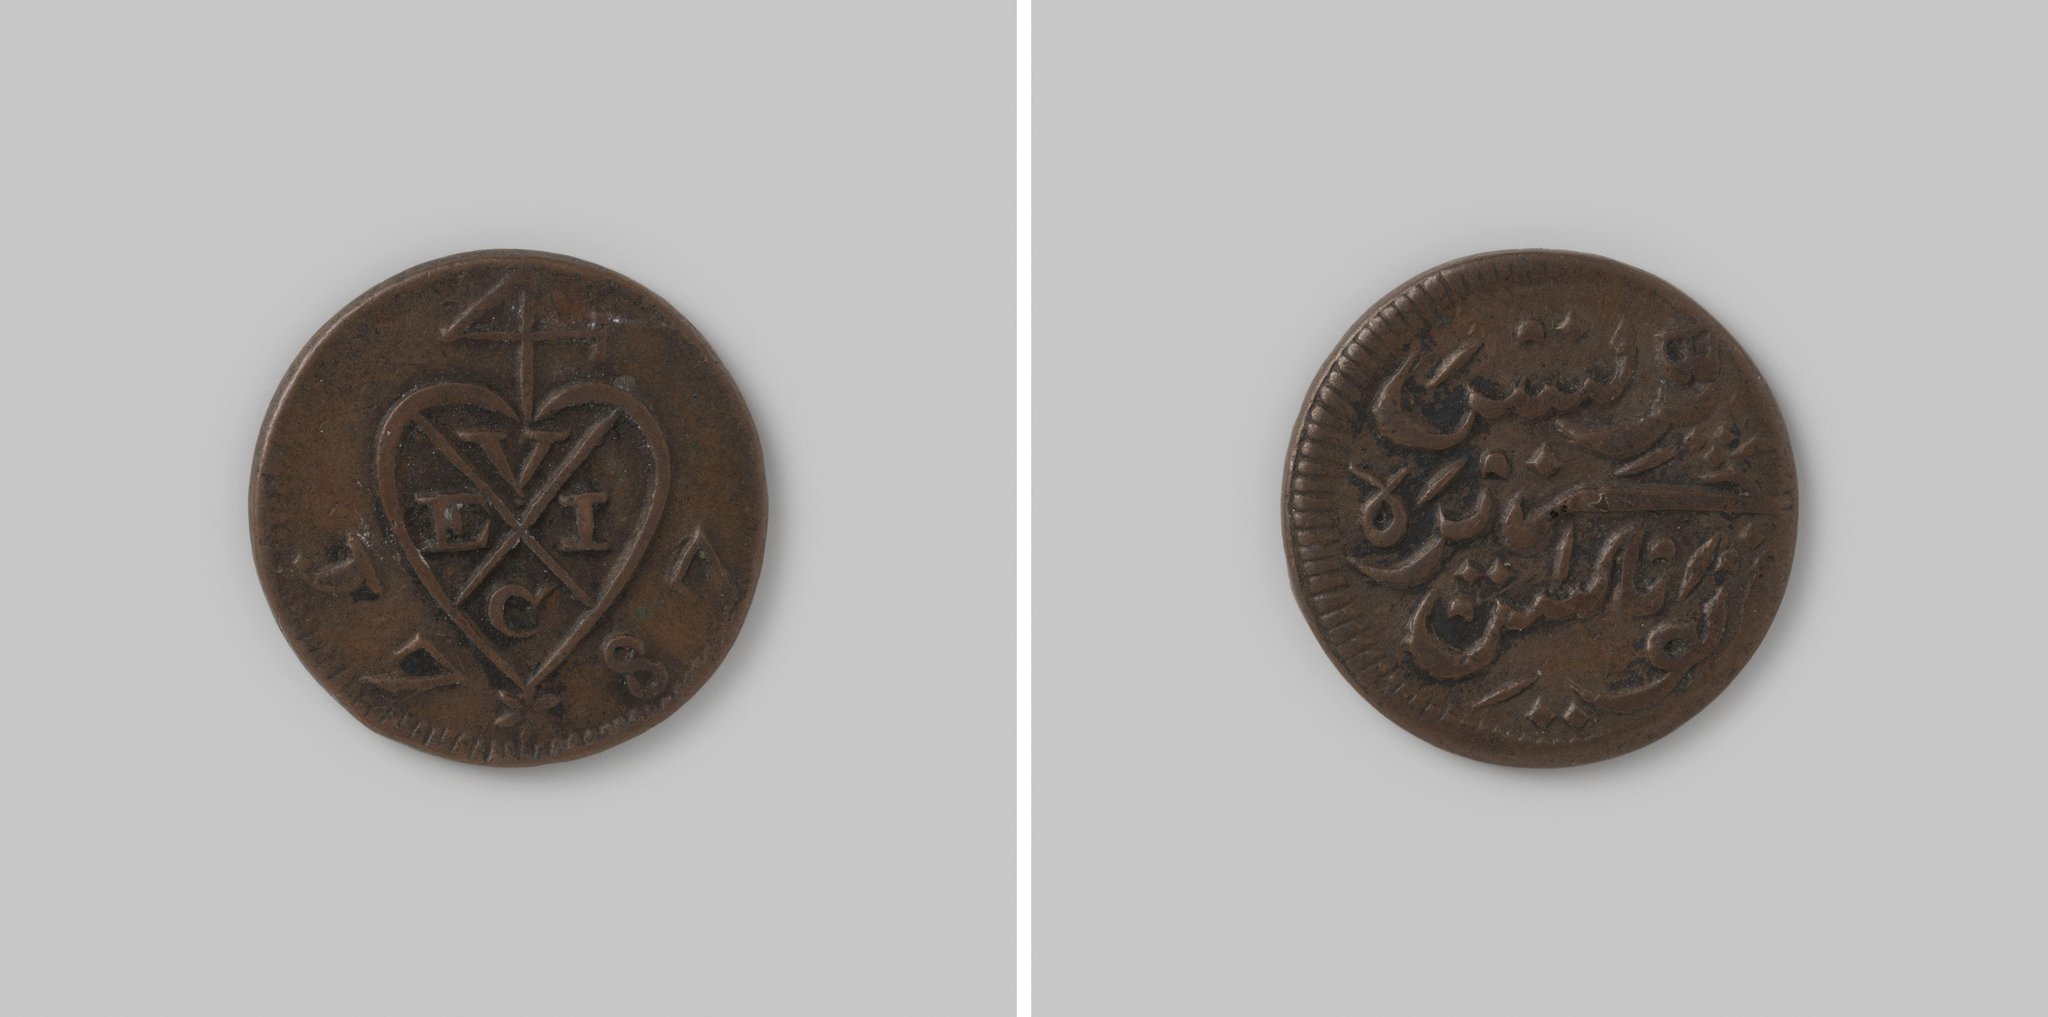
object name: coin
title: alakka, Prince of Wales Island of Pulu Penang, 1/4 cent, 1787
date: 1787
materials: copper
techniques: striking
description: Koperen munt. Voorzijde: hartvormig merk van de Engelse Oostindische Compagnie (EIC), waaronder ster. Jaartal ter weerzijden van het merk. Keerzijde: vierregelig opschrift in Arabische lettertekens: jezirah prins abwails. Gladde rand.